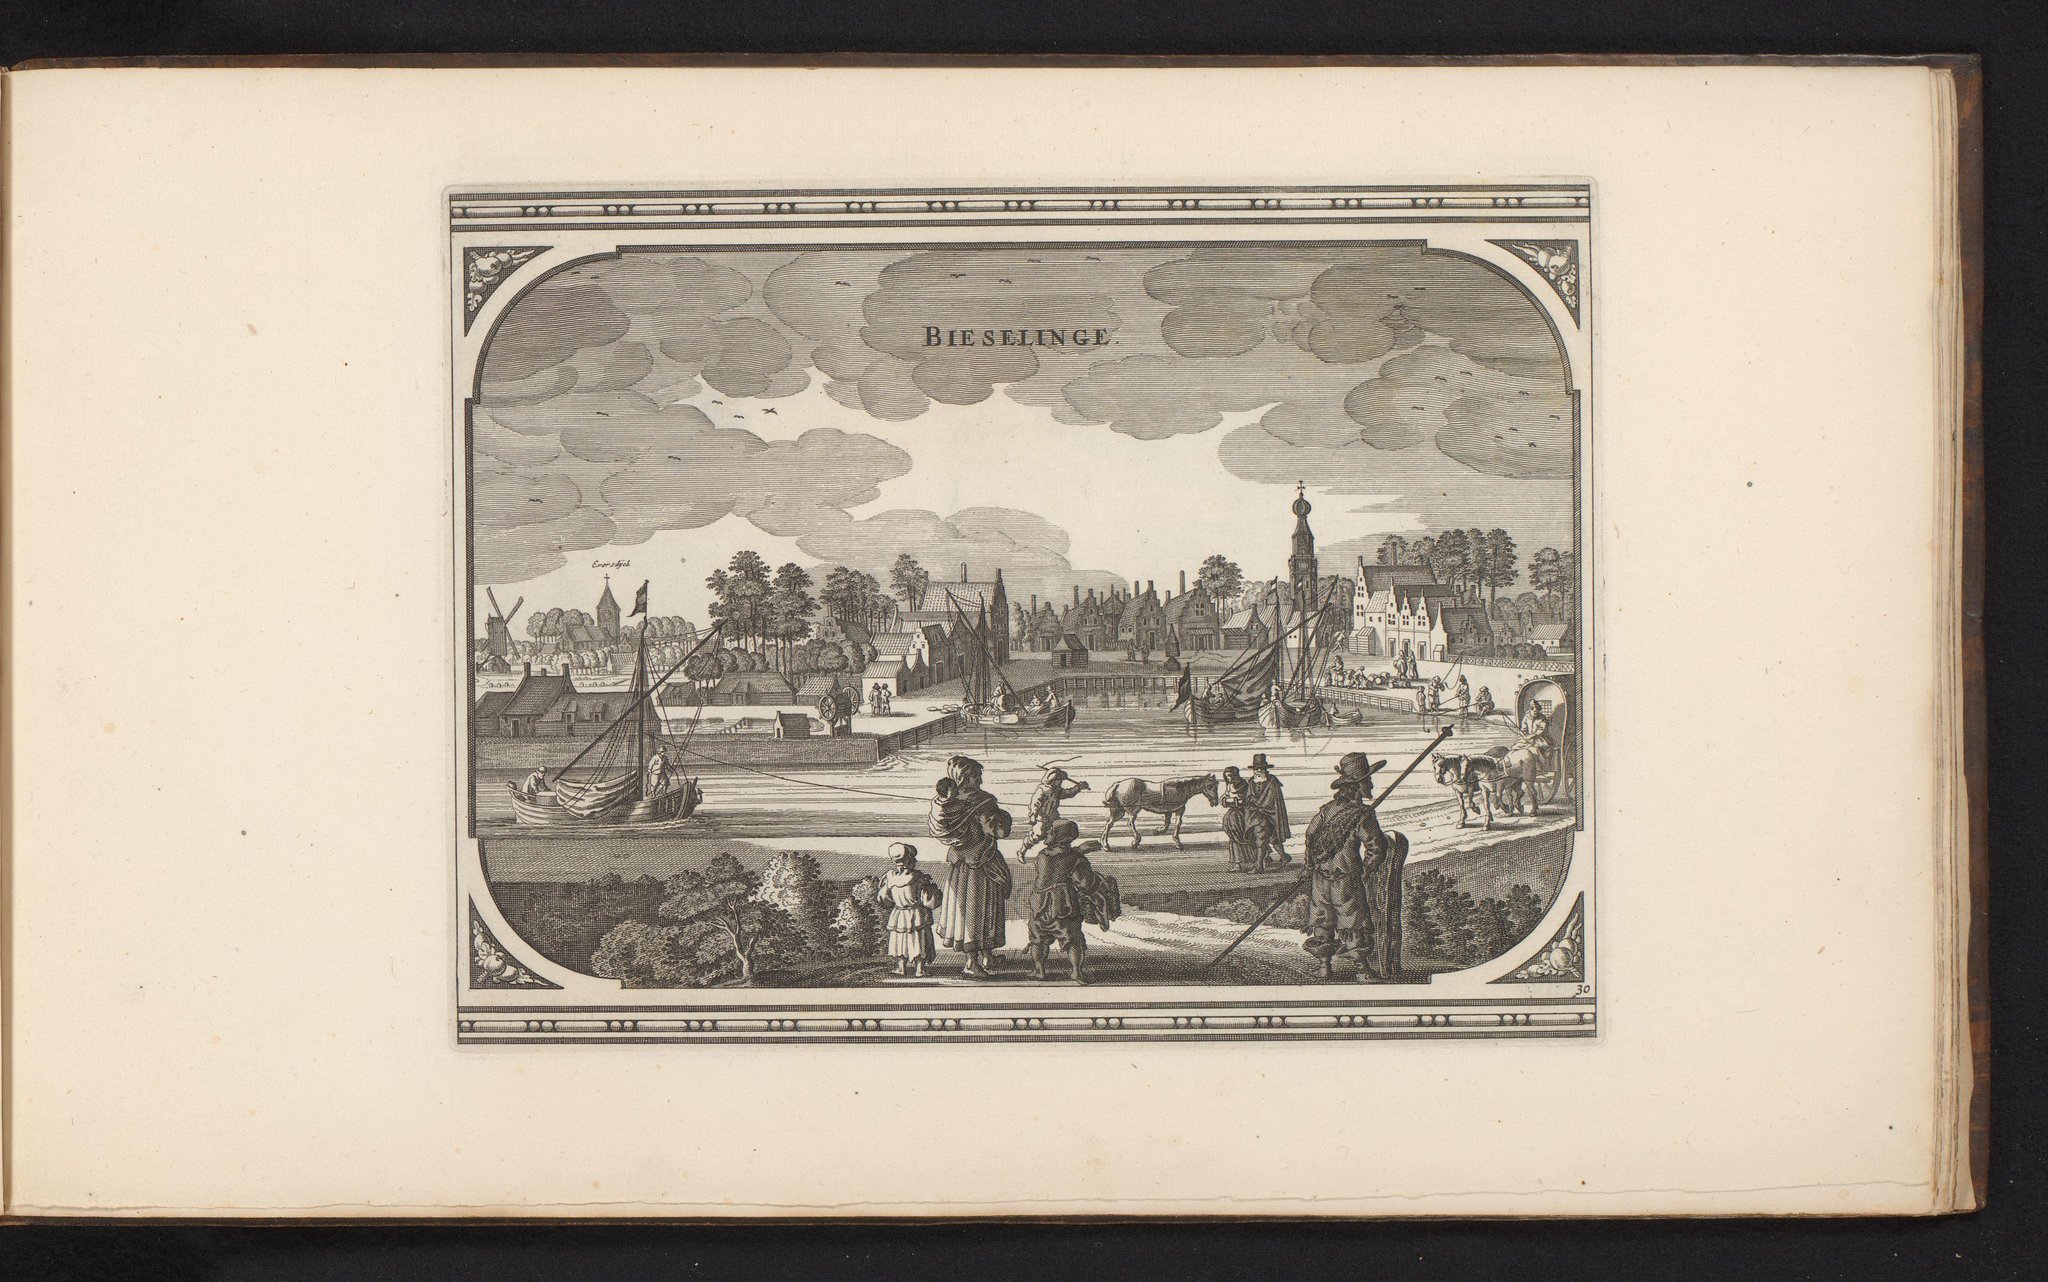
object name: album leaf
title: Speculum Zelandiae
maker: pieter hendricksz. schut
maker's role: print maker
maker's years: 1618-1660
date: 1662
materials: paper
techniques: etching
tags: city-view, and landscape with man-made constructions, boat propelled by man or animal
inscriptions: collector's mark: Lugt 195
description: Gezicht op Biezelinge met links de kerk van Eversdijk. De boot op de rivier wordt voortgetrokken door een paard. Rechts een rijtuig. De prent maakt deel uit van een album.